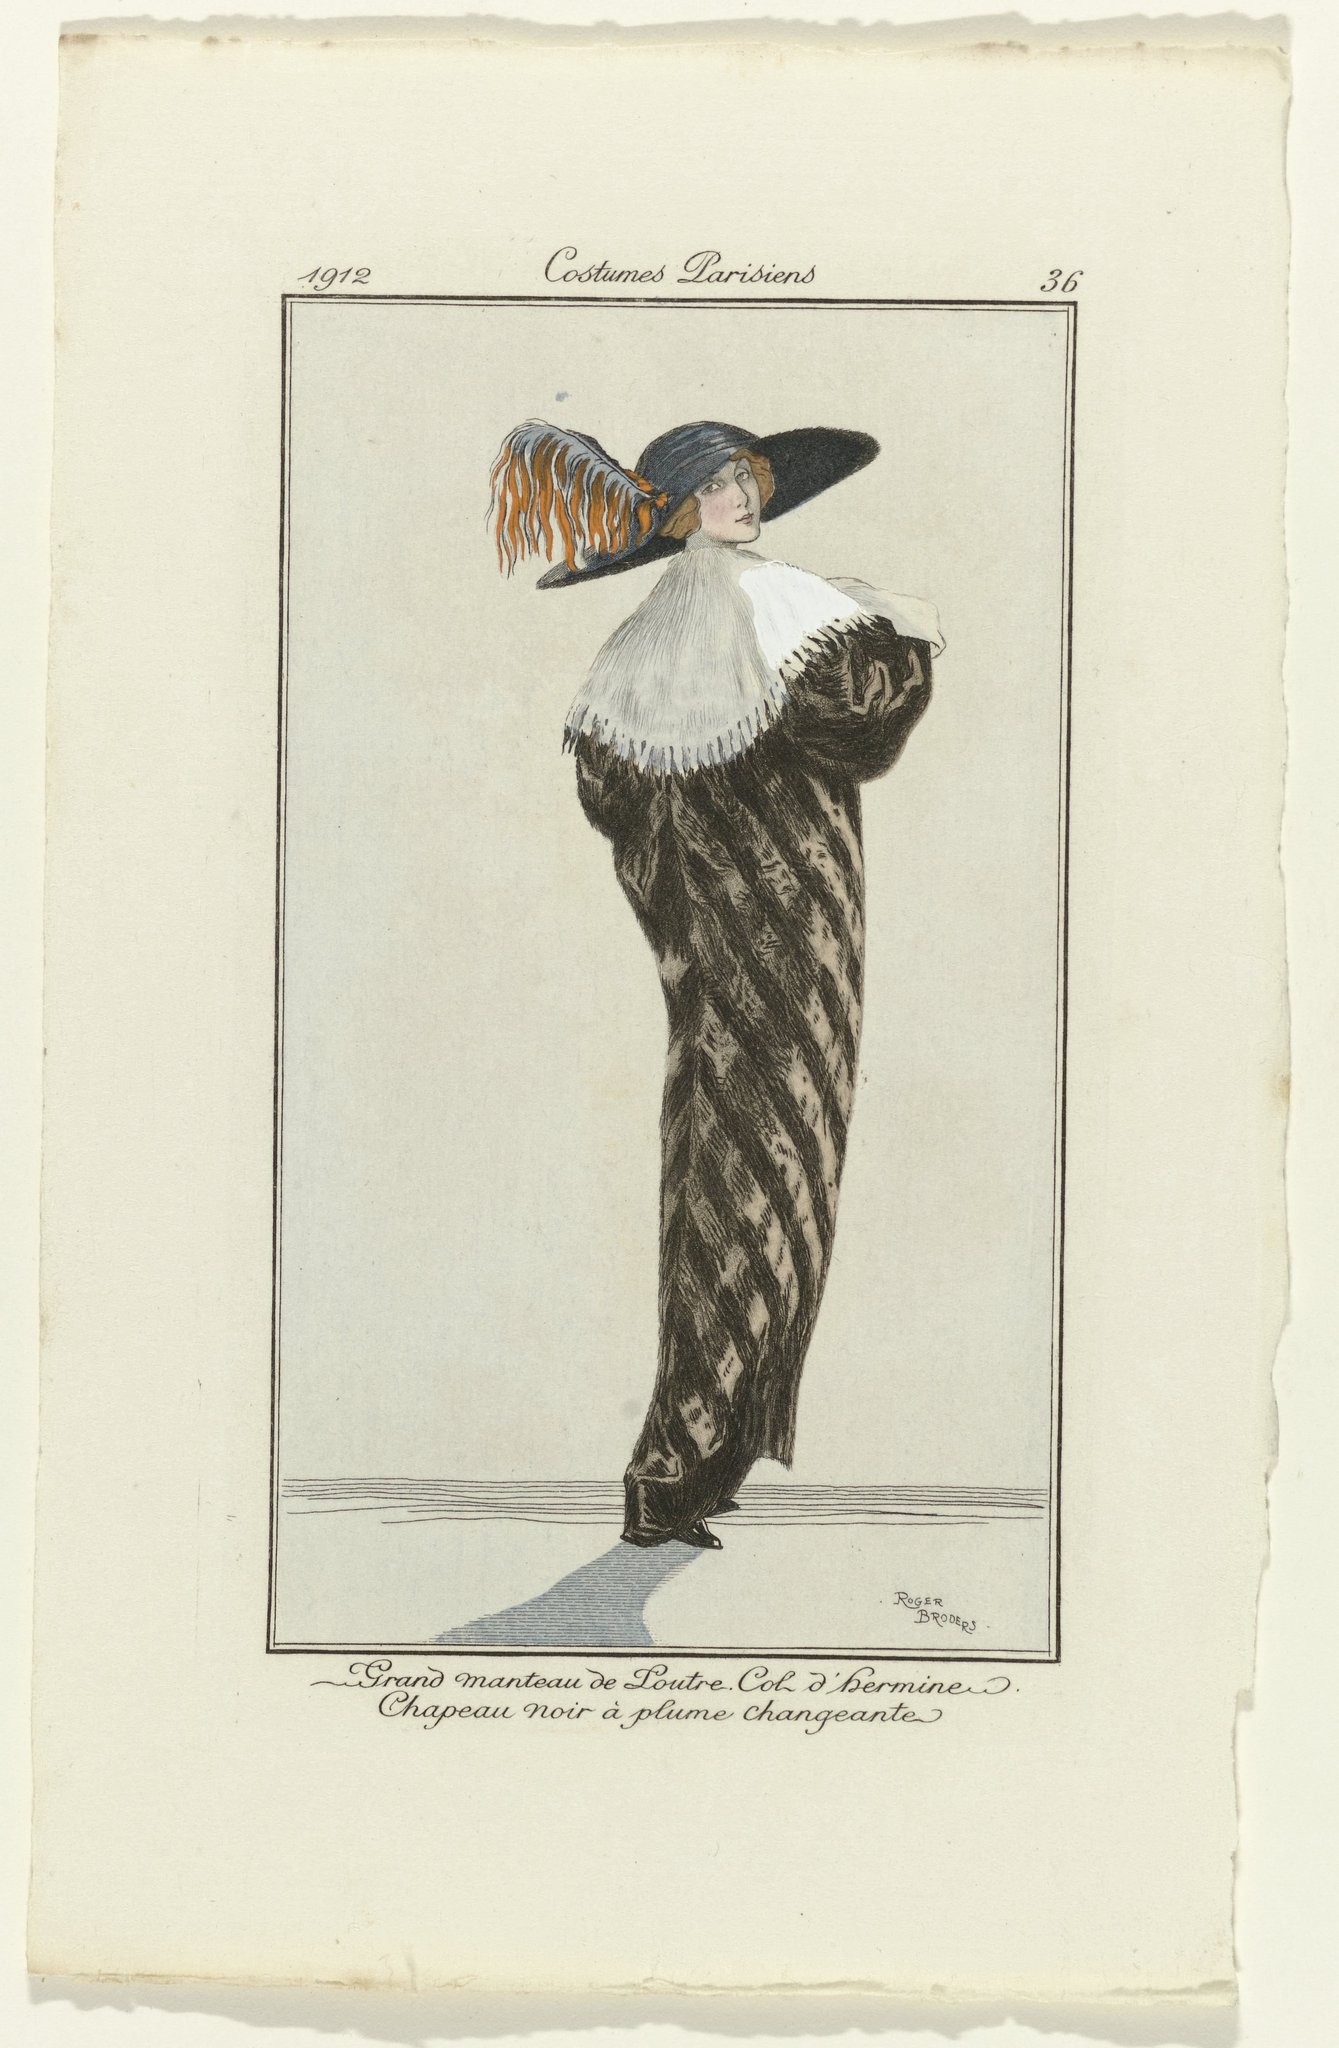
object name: fashion print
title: Journal des Dames et des Modes: Fashion News Journal des Dames et des Modes: the Fashion Illustrators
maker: Anonymous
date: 1912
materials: paper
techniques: engraving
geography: paris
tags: fashion plates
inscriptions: caption: ‘Grand Manteau de Loutre, Col d'Hermine. Chapeau noir à plume changeante’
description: The Journal des Dames was inspired by the eponymous fashion magazine from the previous century and, like the earlier publication, referred to its illustrations as Costumes Parisiens. These Costumes Parisiens (184 illustrations in total) were drawn in a new, flat, decorative manner by George Barbier, Jan van Brock, Victor Lhuer and other Parisian artists, each with a signature style. Every issue came with two or three separate plates. These showed a wide variety of fashionable apparel, from elegant evening attire to outdoor outfits. A brief caption provides the name of the garment and the material from which it was made, but never the name of a fashion house.